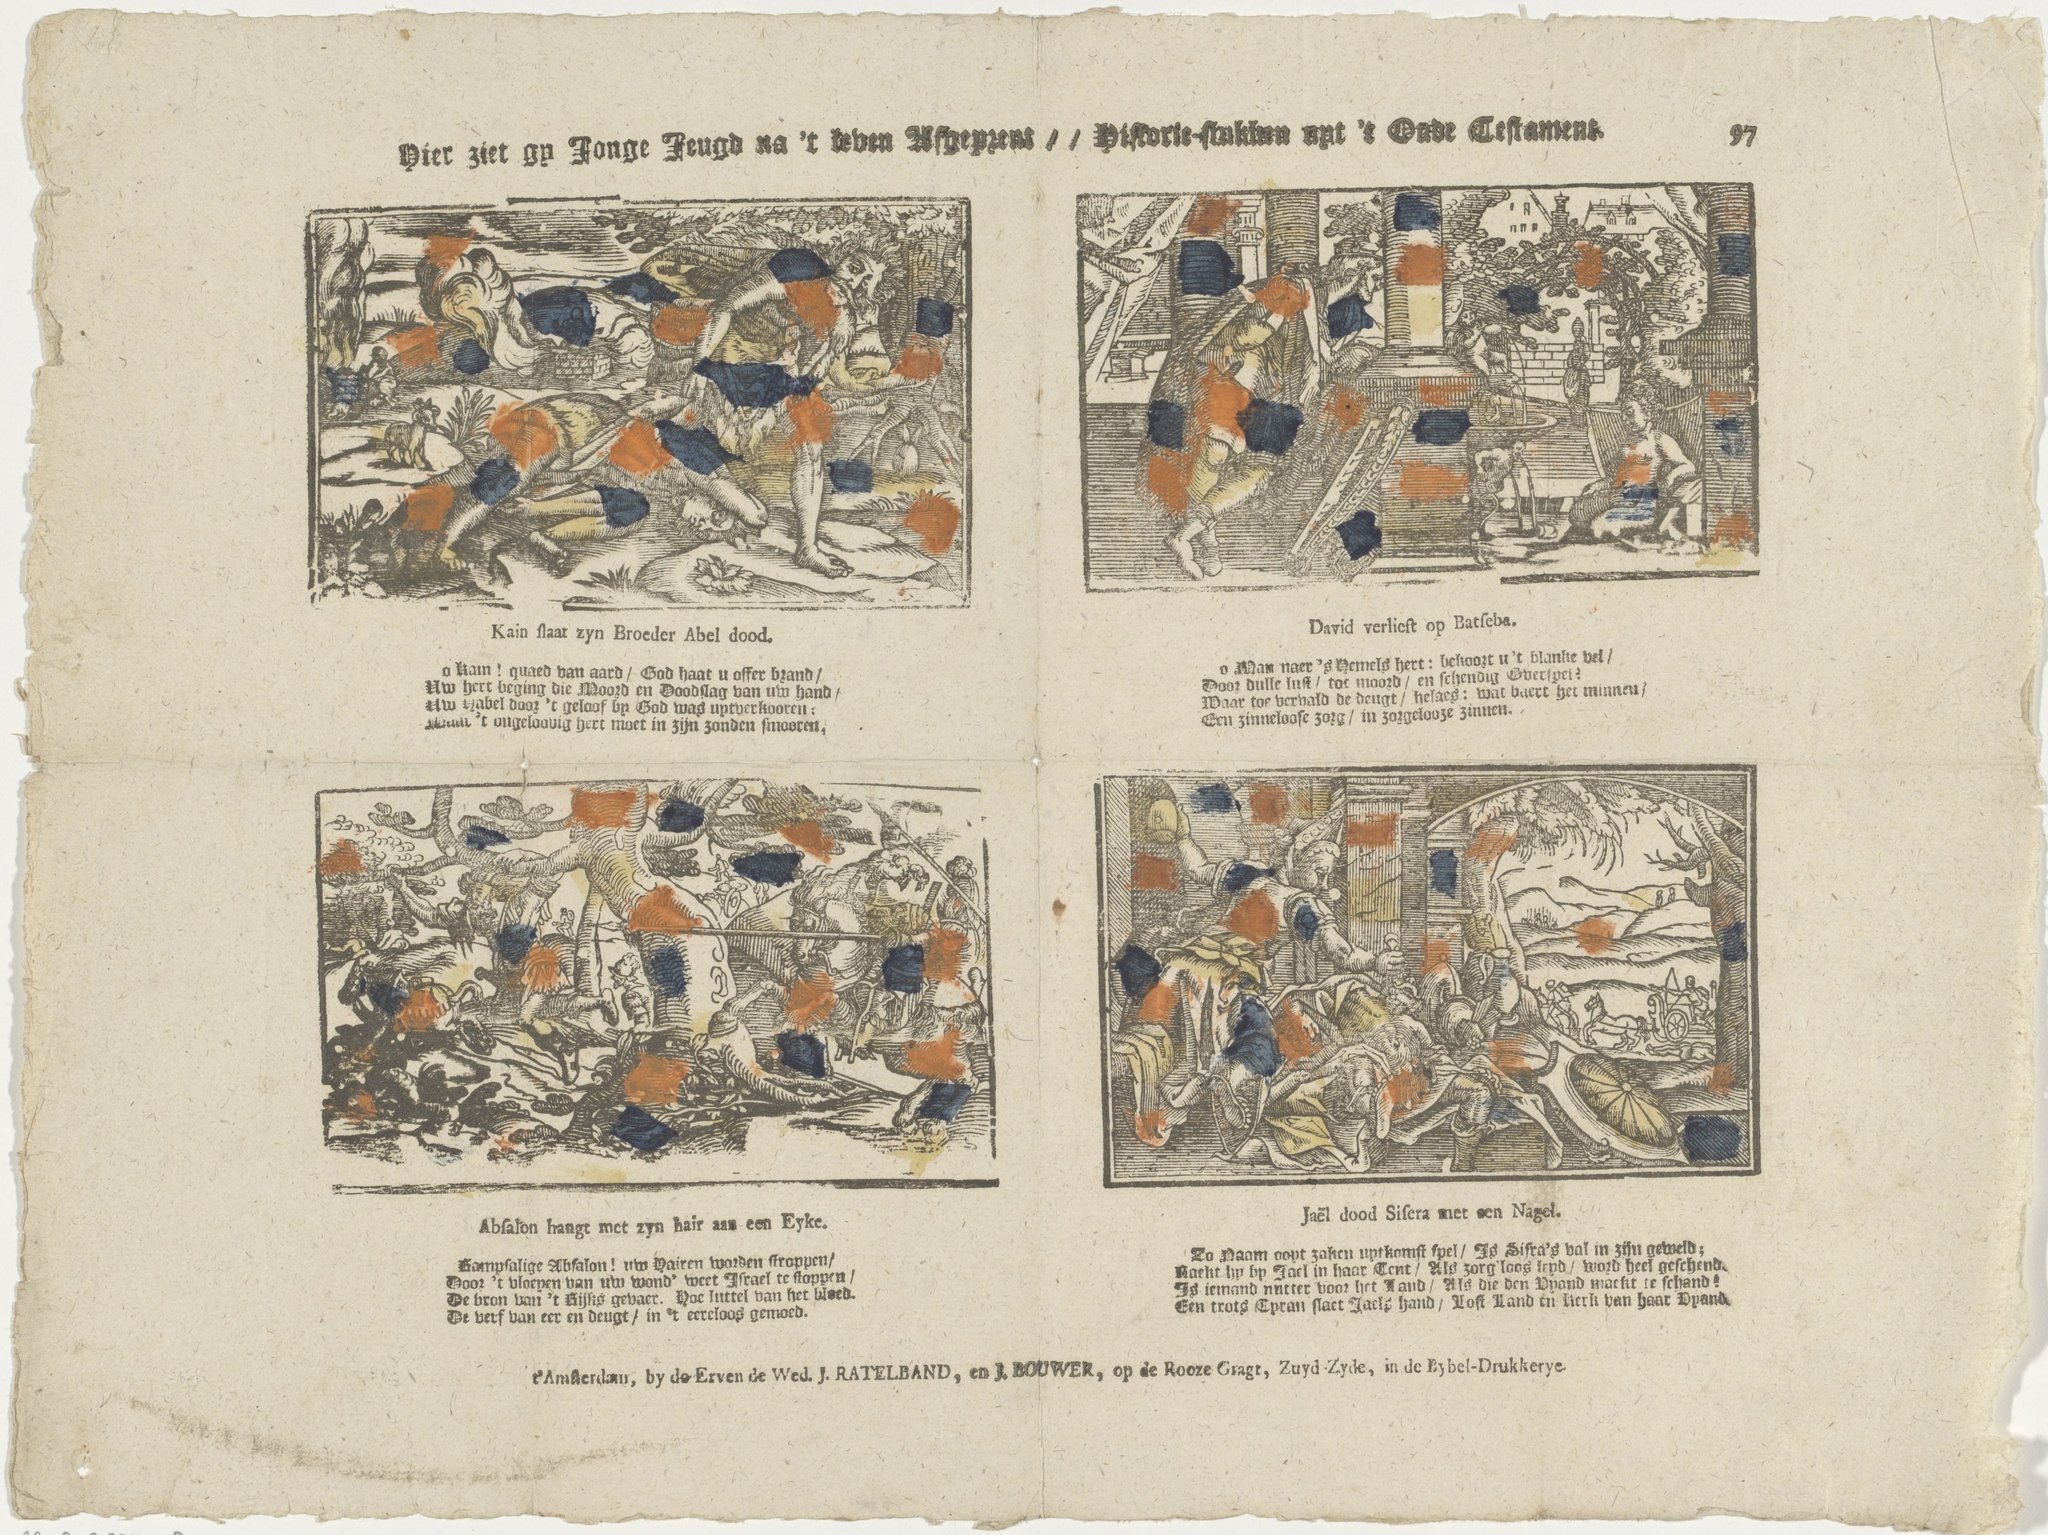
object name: popular print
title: Hier ziet gij jonge jeugd na 't leven afgeprent // Historie-stukken uyt 't Oude Testament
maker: Anonymous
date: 1782-1793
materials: paper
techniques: colour, letterpress printing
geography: netherlands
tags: abel's death, jael kills the sleeping sisera by hitting the nail through his temples, david and bathsheba (2 samuel 11-12), absalom, put to flight on a mule, remains hanging by his hair in an oak-tree, old testament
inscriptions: collector's mark: Lugt 2760, collector's mark: Lugt 2228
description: Blad met 4 voorstellingen van verhalen uit het Oude Testament: de dood van Abel, David wordt verliefd op Batseba, Absalom hangt aan zijn haar in een boom en Jaël doodt Sisera. Onder elke afbeelding een titel en een vierregelig vers. Genummerd rechtsboven: 97.